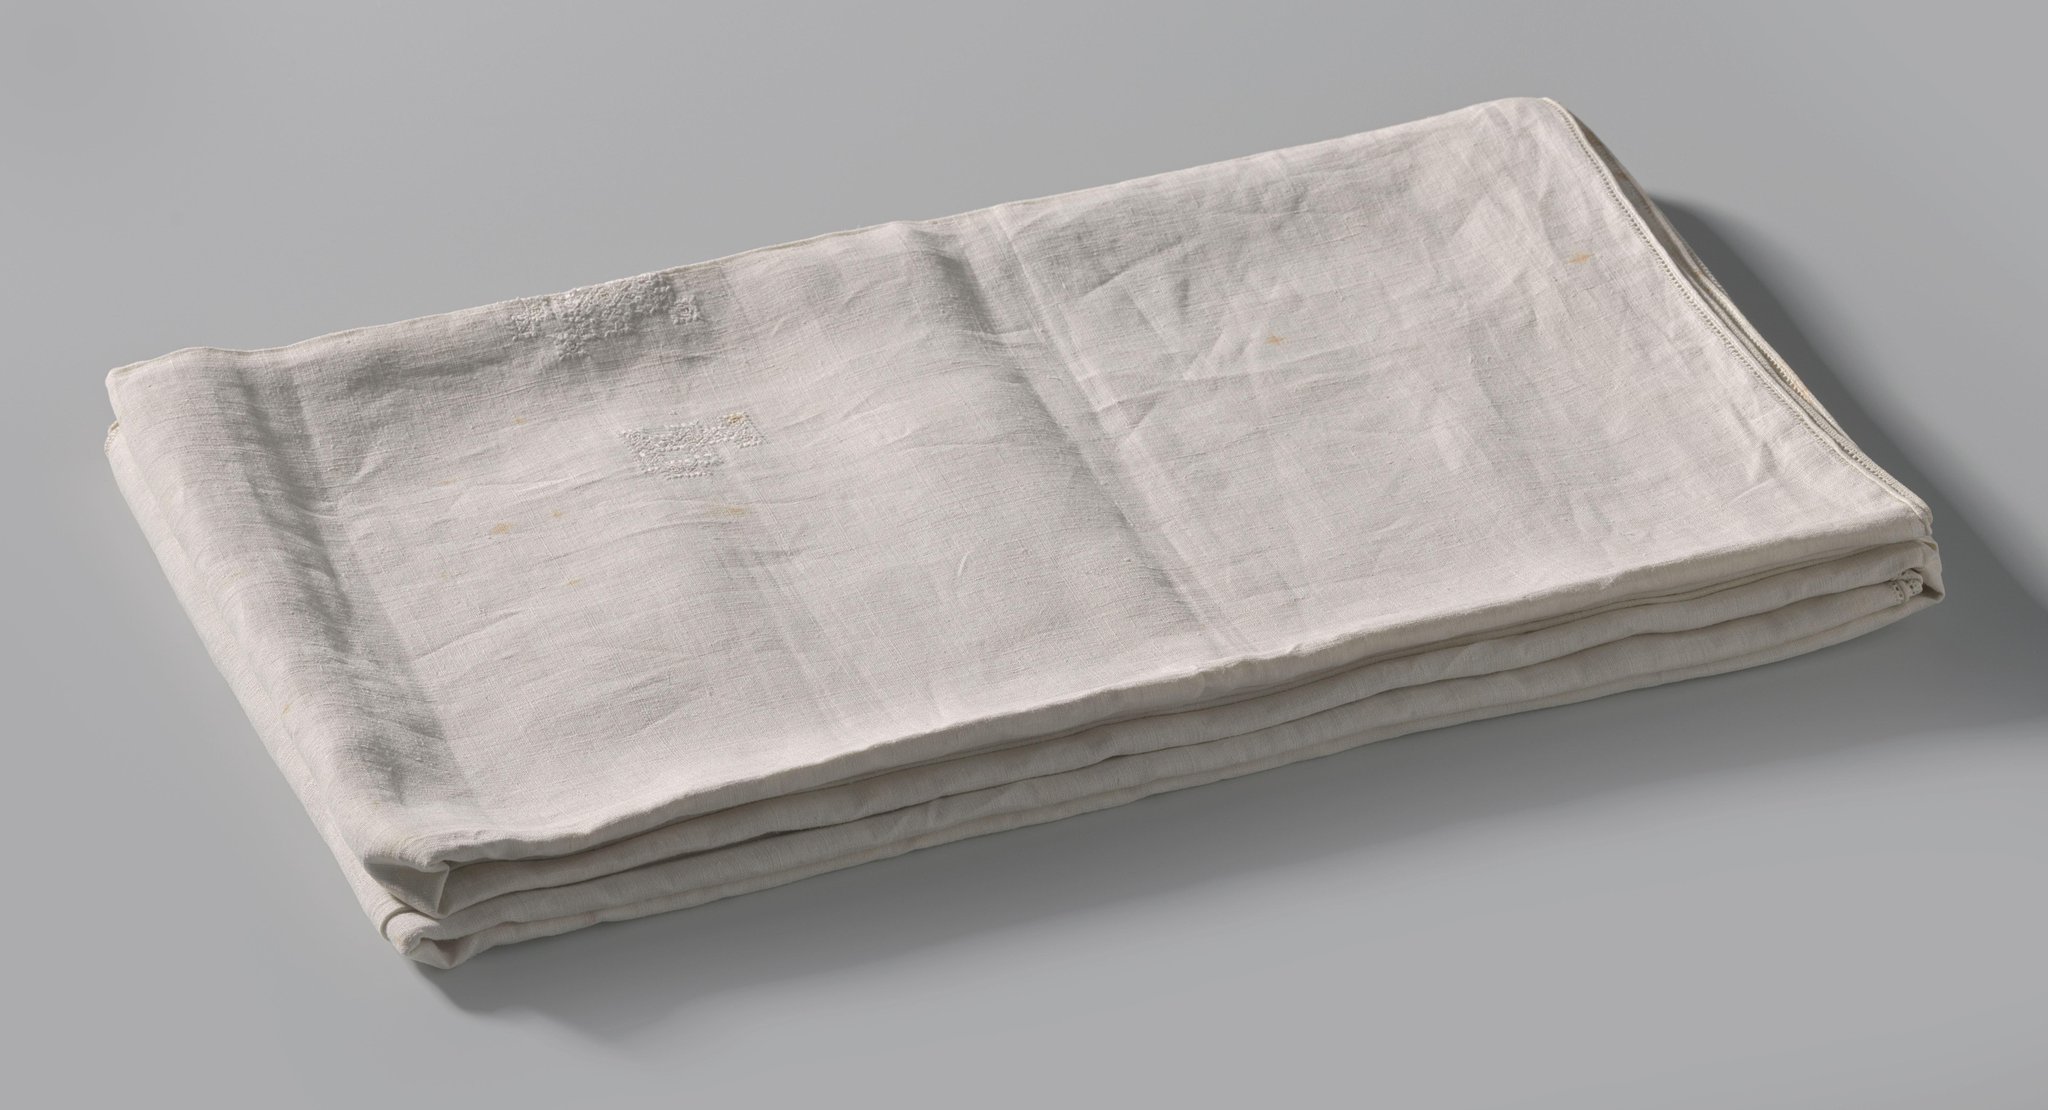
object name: beddenlaken, laken object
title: Laken van twee banen linnen, verbonden met entre-deux van kloskant. OP omslag initialen T en P in wit borduurwerk (2x).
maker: Anonymous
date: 1650-1700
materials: linen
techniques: lace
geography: netherlands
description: Beddenlaken van twee banen linnen, verbonden met entre-deux van kloskant met afwisselend zandloper en radmotief. Op omslag tweemaal zeer grote initialen T en P in wit borduurwerk ter weerszijden van een groot gekroond (?) hartvormig ornament. Laken rondom afgewerkt met open zoom.